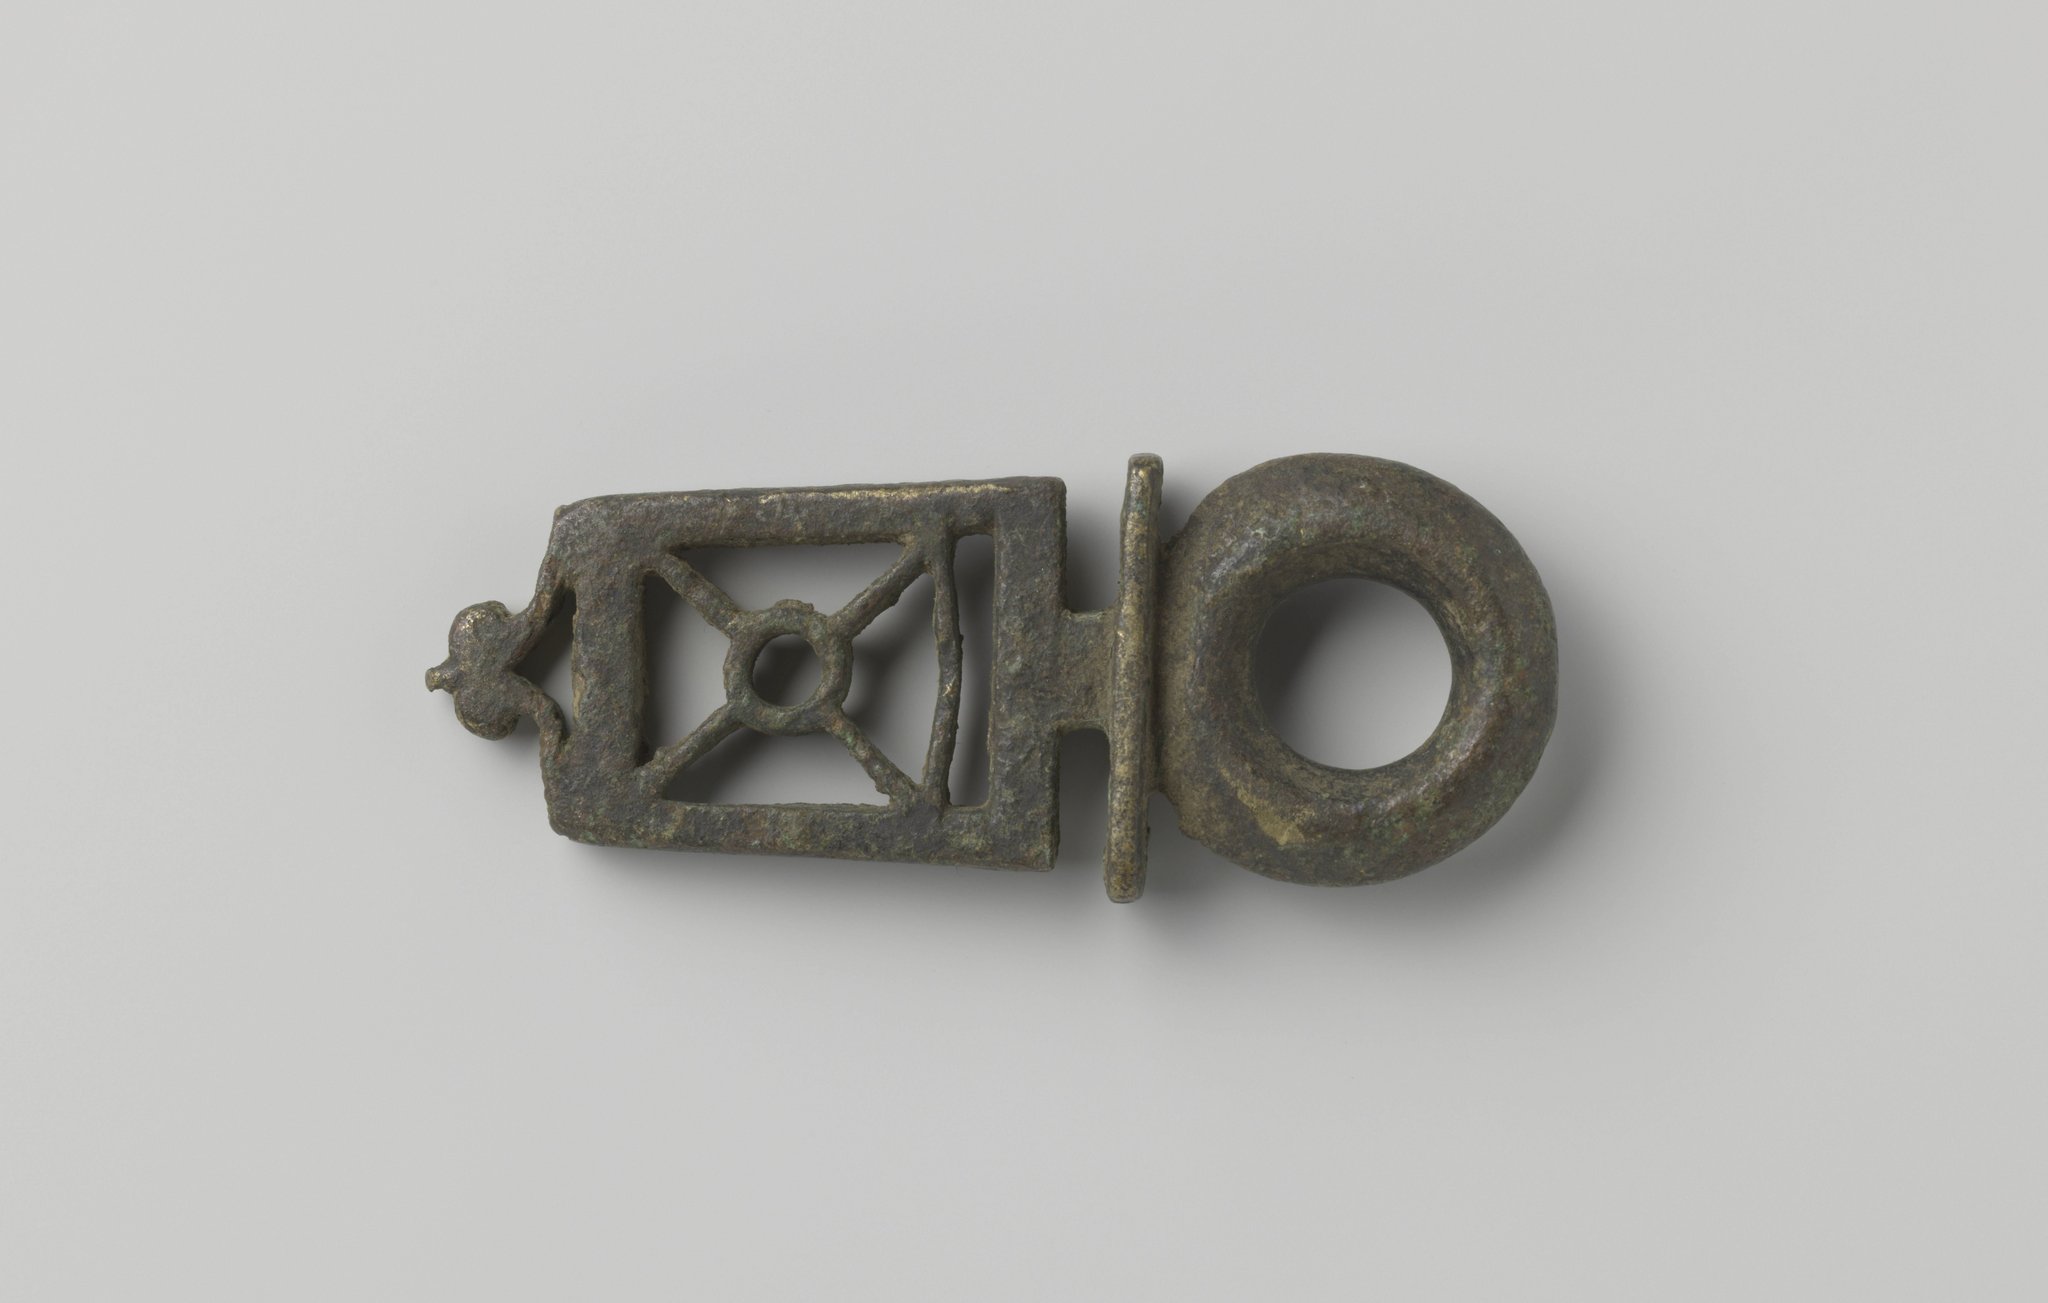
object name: schuifsleutel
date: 1400-1950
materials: bronze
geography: rome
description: Schuifsleutel met oog gelijkend op een zware ring op een dunne, platte sleutelborst. De baard loopt in een bladmotief uit.